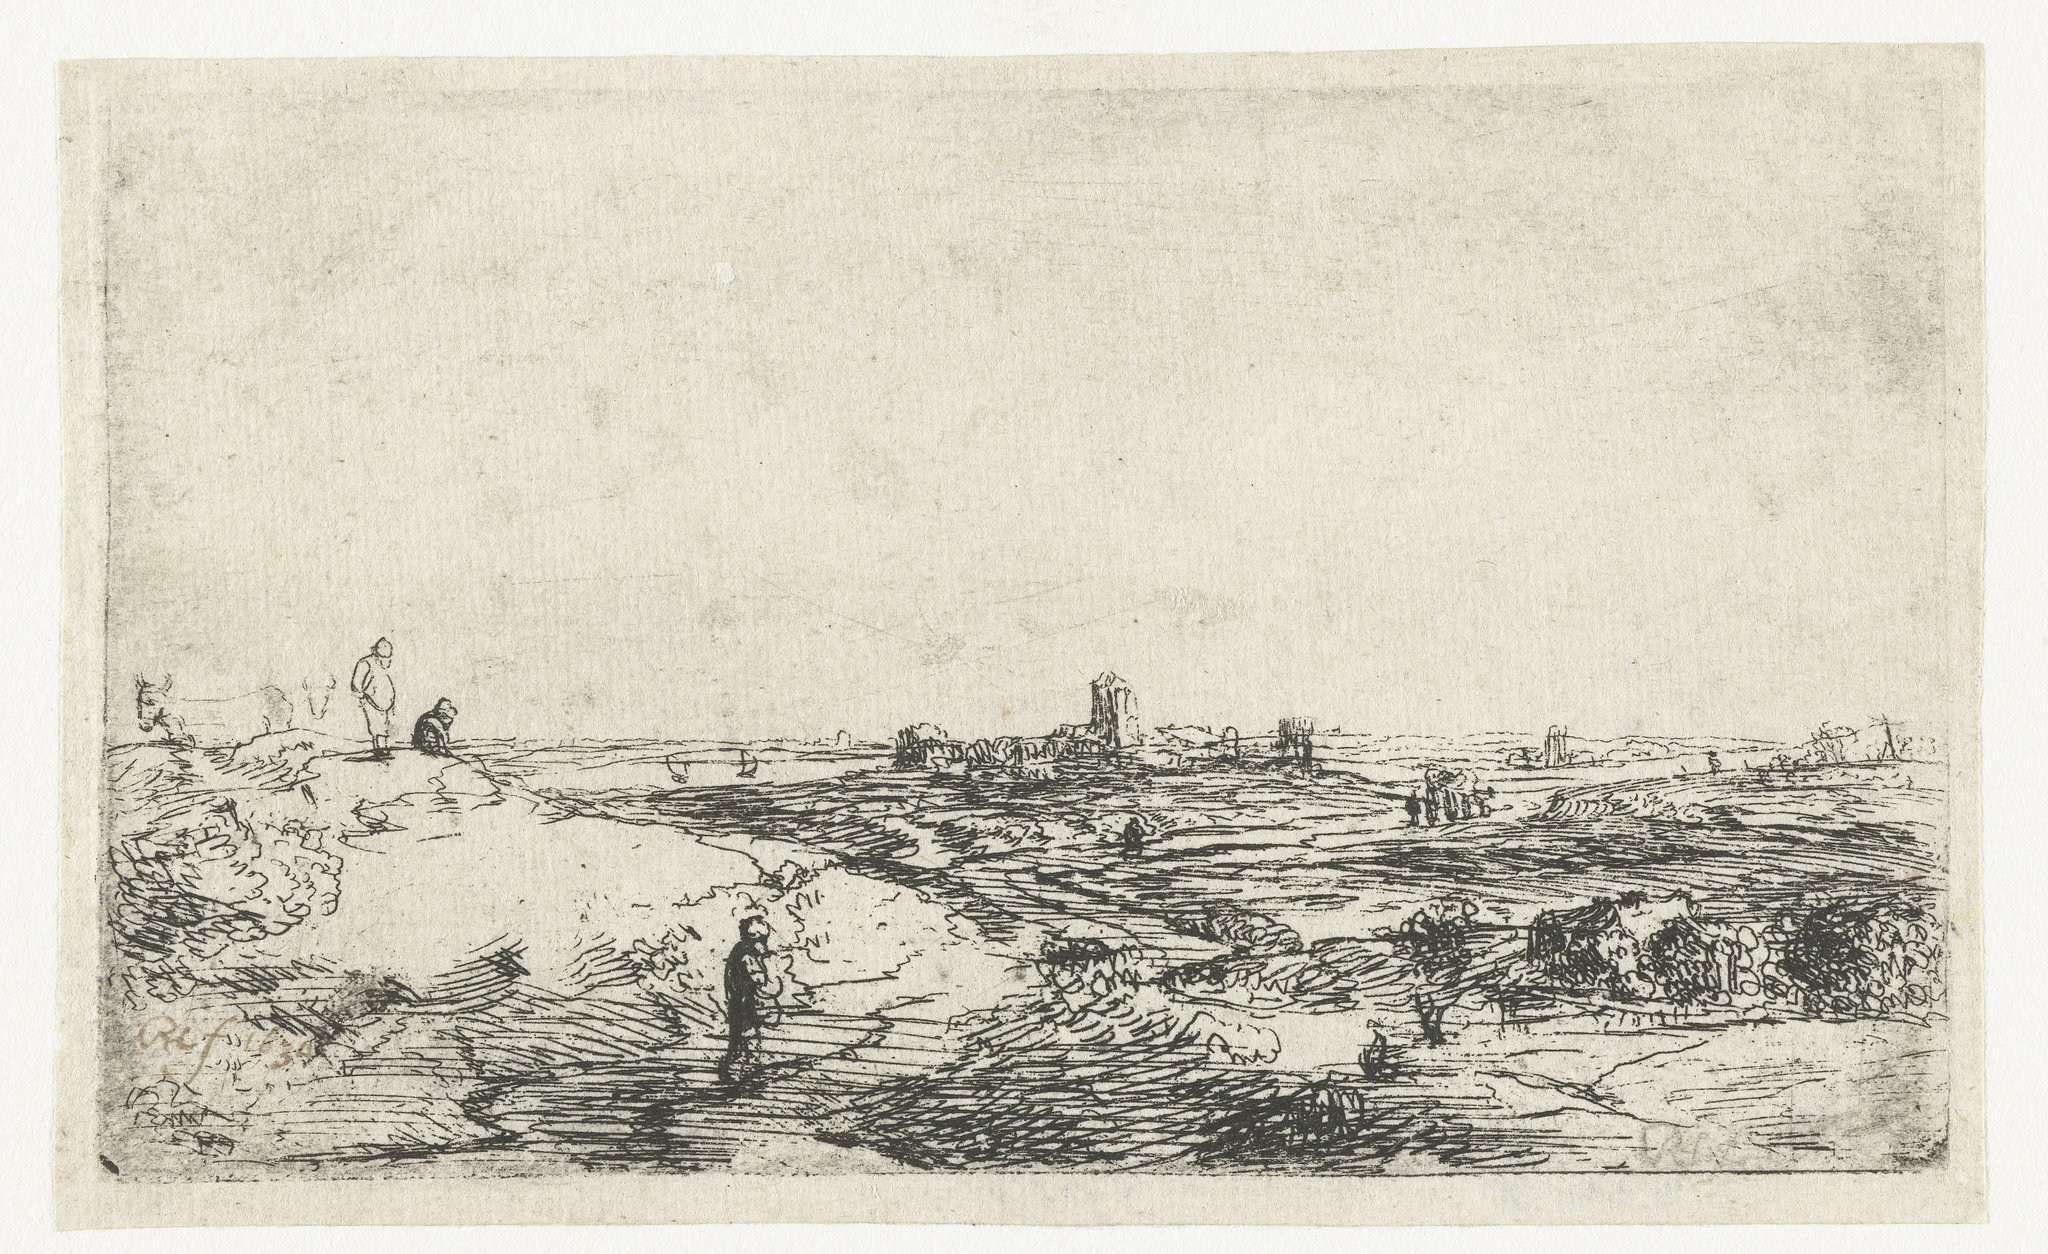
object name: print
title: Landschap met een koe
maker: Anonymous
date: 1630-1700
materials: paper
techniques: etching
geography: netherlands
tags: low hill country, cow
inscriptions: inscription: ‘R H(?) L’, inscription: ‘Re f 1630’, collector's mark: Lugt 240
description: De signatuur lijkt volgens Hollstein (Rembrandt, p. 178, cat.nr. 206) niet authentiek. Door Münz (cat.nr. 354) toegeschreven aan Roghman. Volgens Hollstein is de prent gerelateerd aan een aantal van de vroege landschapstekeningen van Rembrandt, maar ook aan het vroege werk van Lievens.